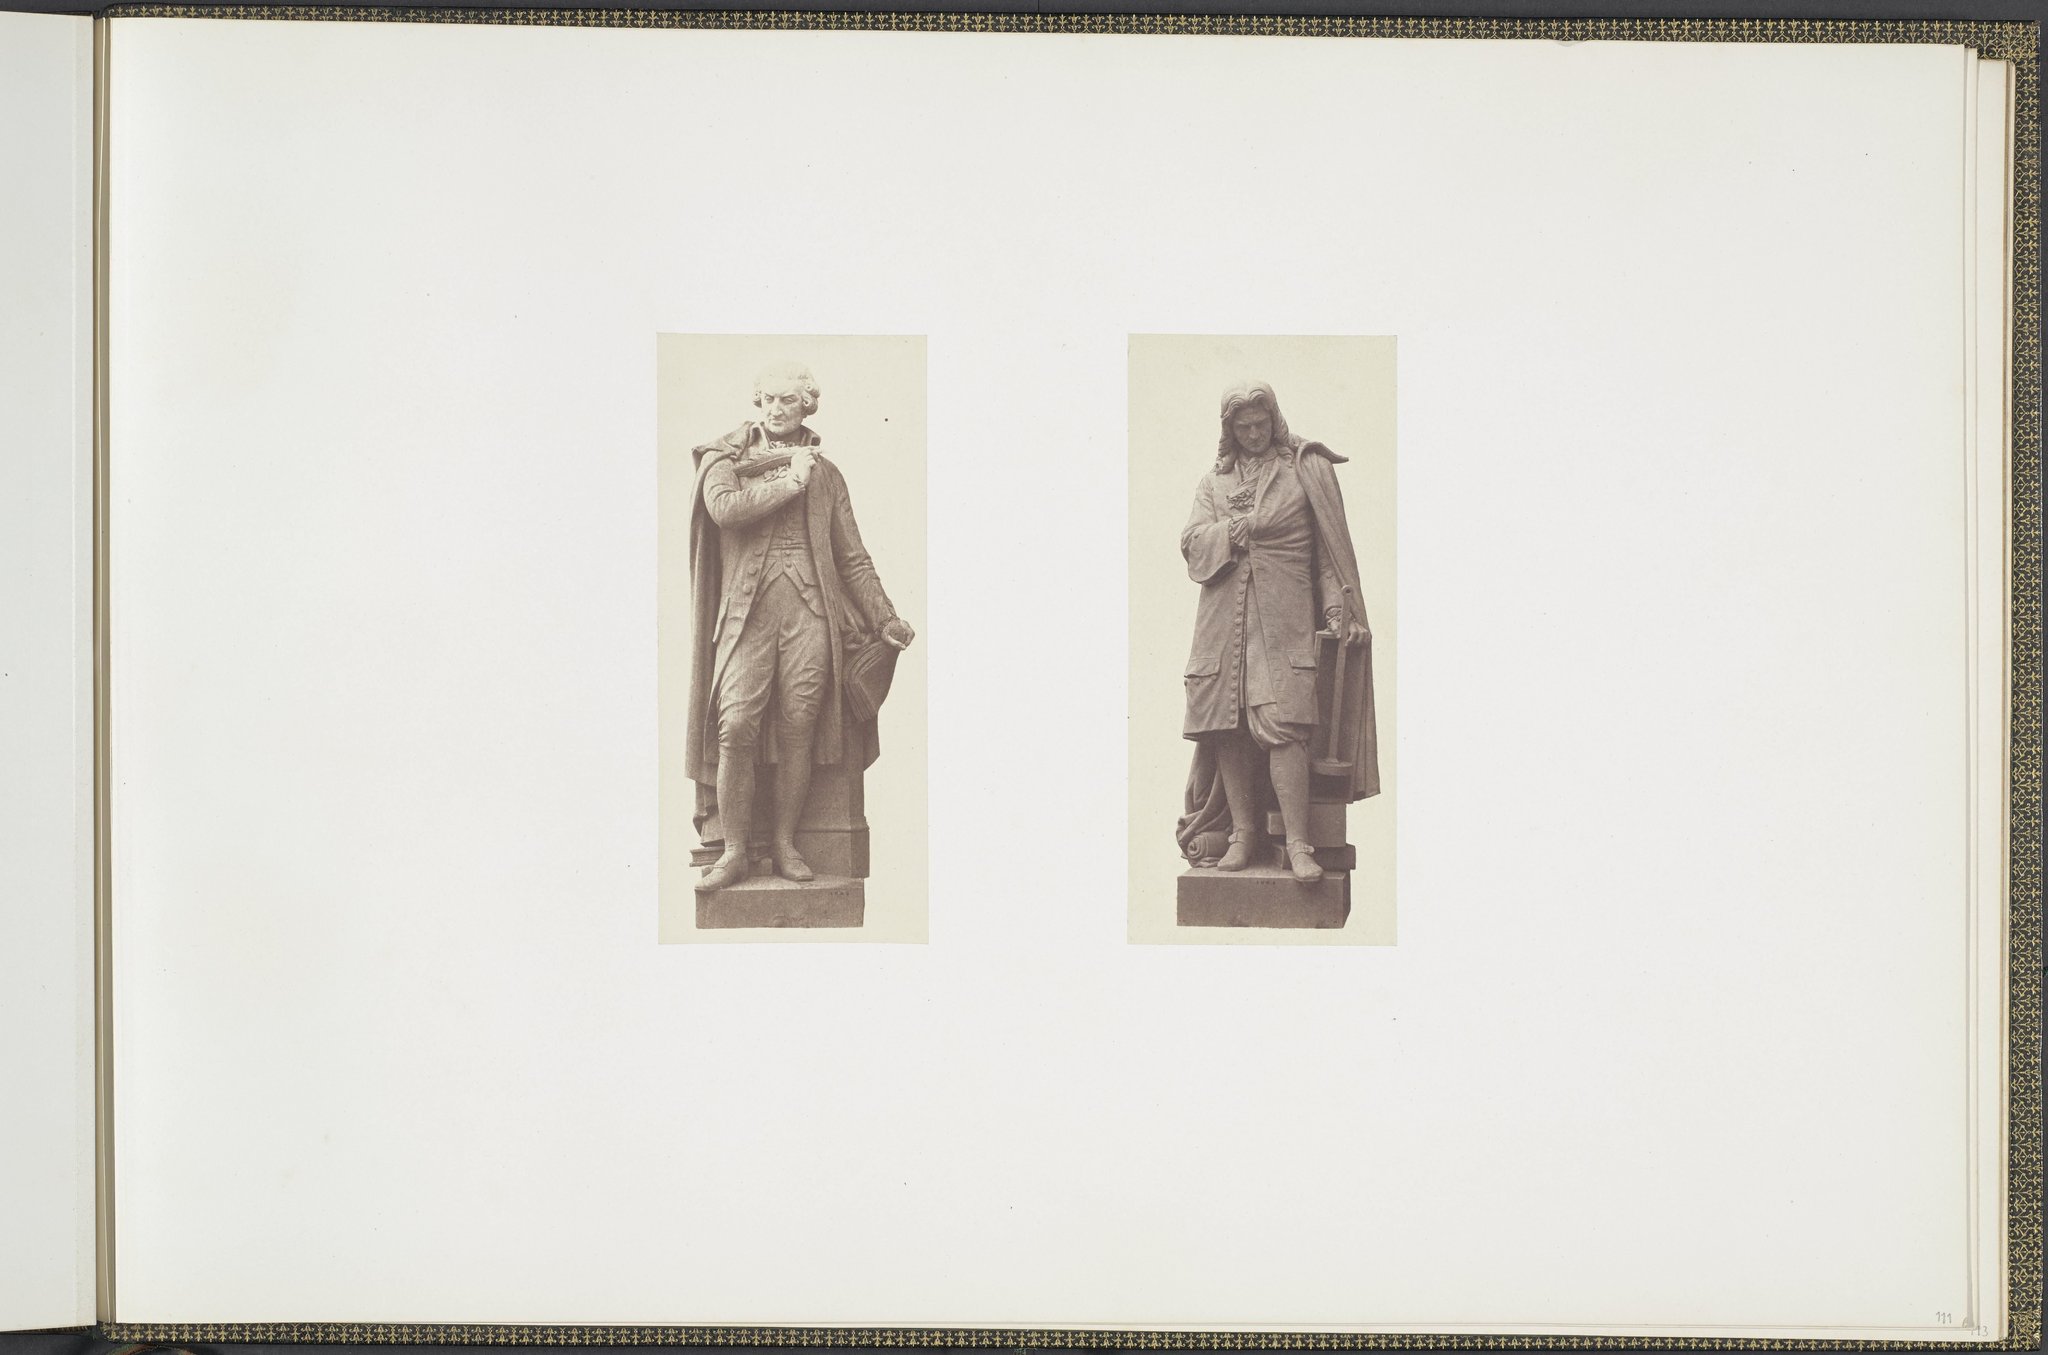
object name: photograph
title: Gipsmodellen voor beeldhouwwerken op het Palais du Louvre: links "Condorcet" door Pierre Loison en rechts "Papin" door Jean-François Soitoux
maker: édouard denis baldus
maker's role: fotograaf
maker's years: 1813-1889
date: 1855-1857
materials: paper, photographic support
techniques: salted paper print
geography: paris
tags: piece of sculpture, reproduction of a piece of sculpture, permanent exhibition, museum, paris, tuileries palace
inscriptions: number: ‘[...]’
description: Onderdeel van Réunion des Tuileries au Louvre 1852-1857, album 1.